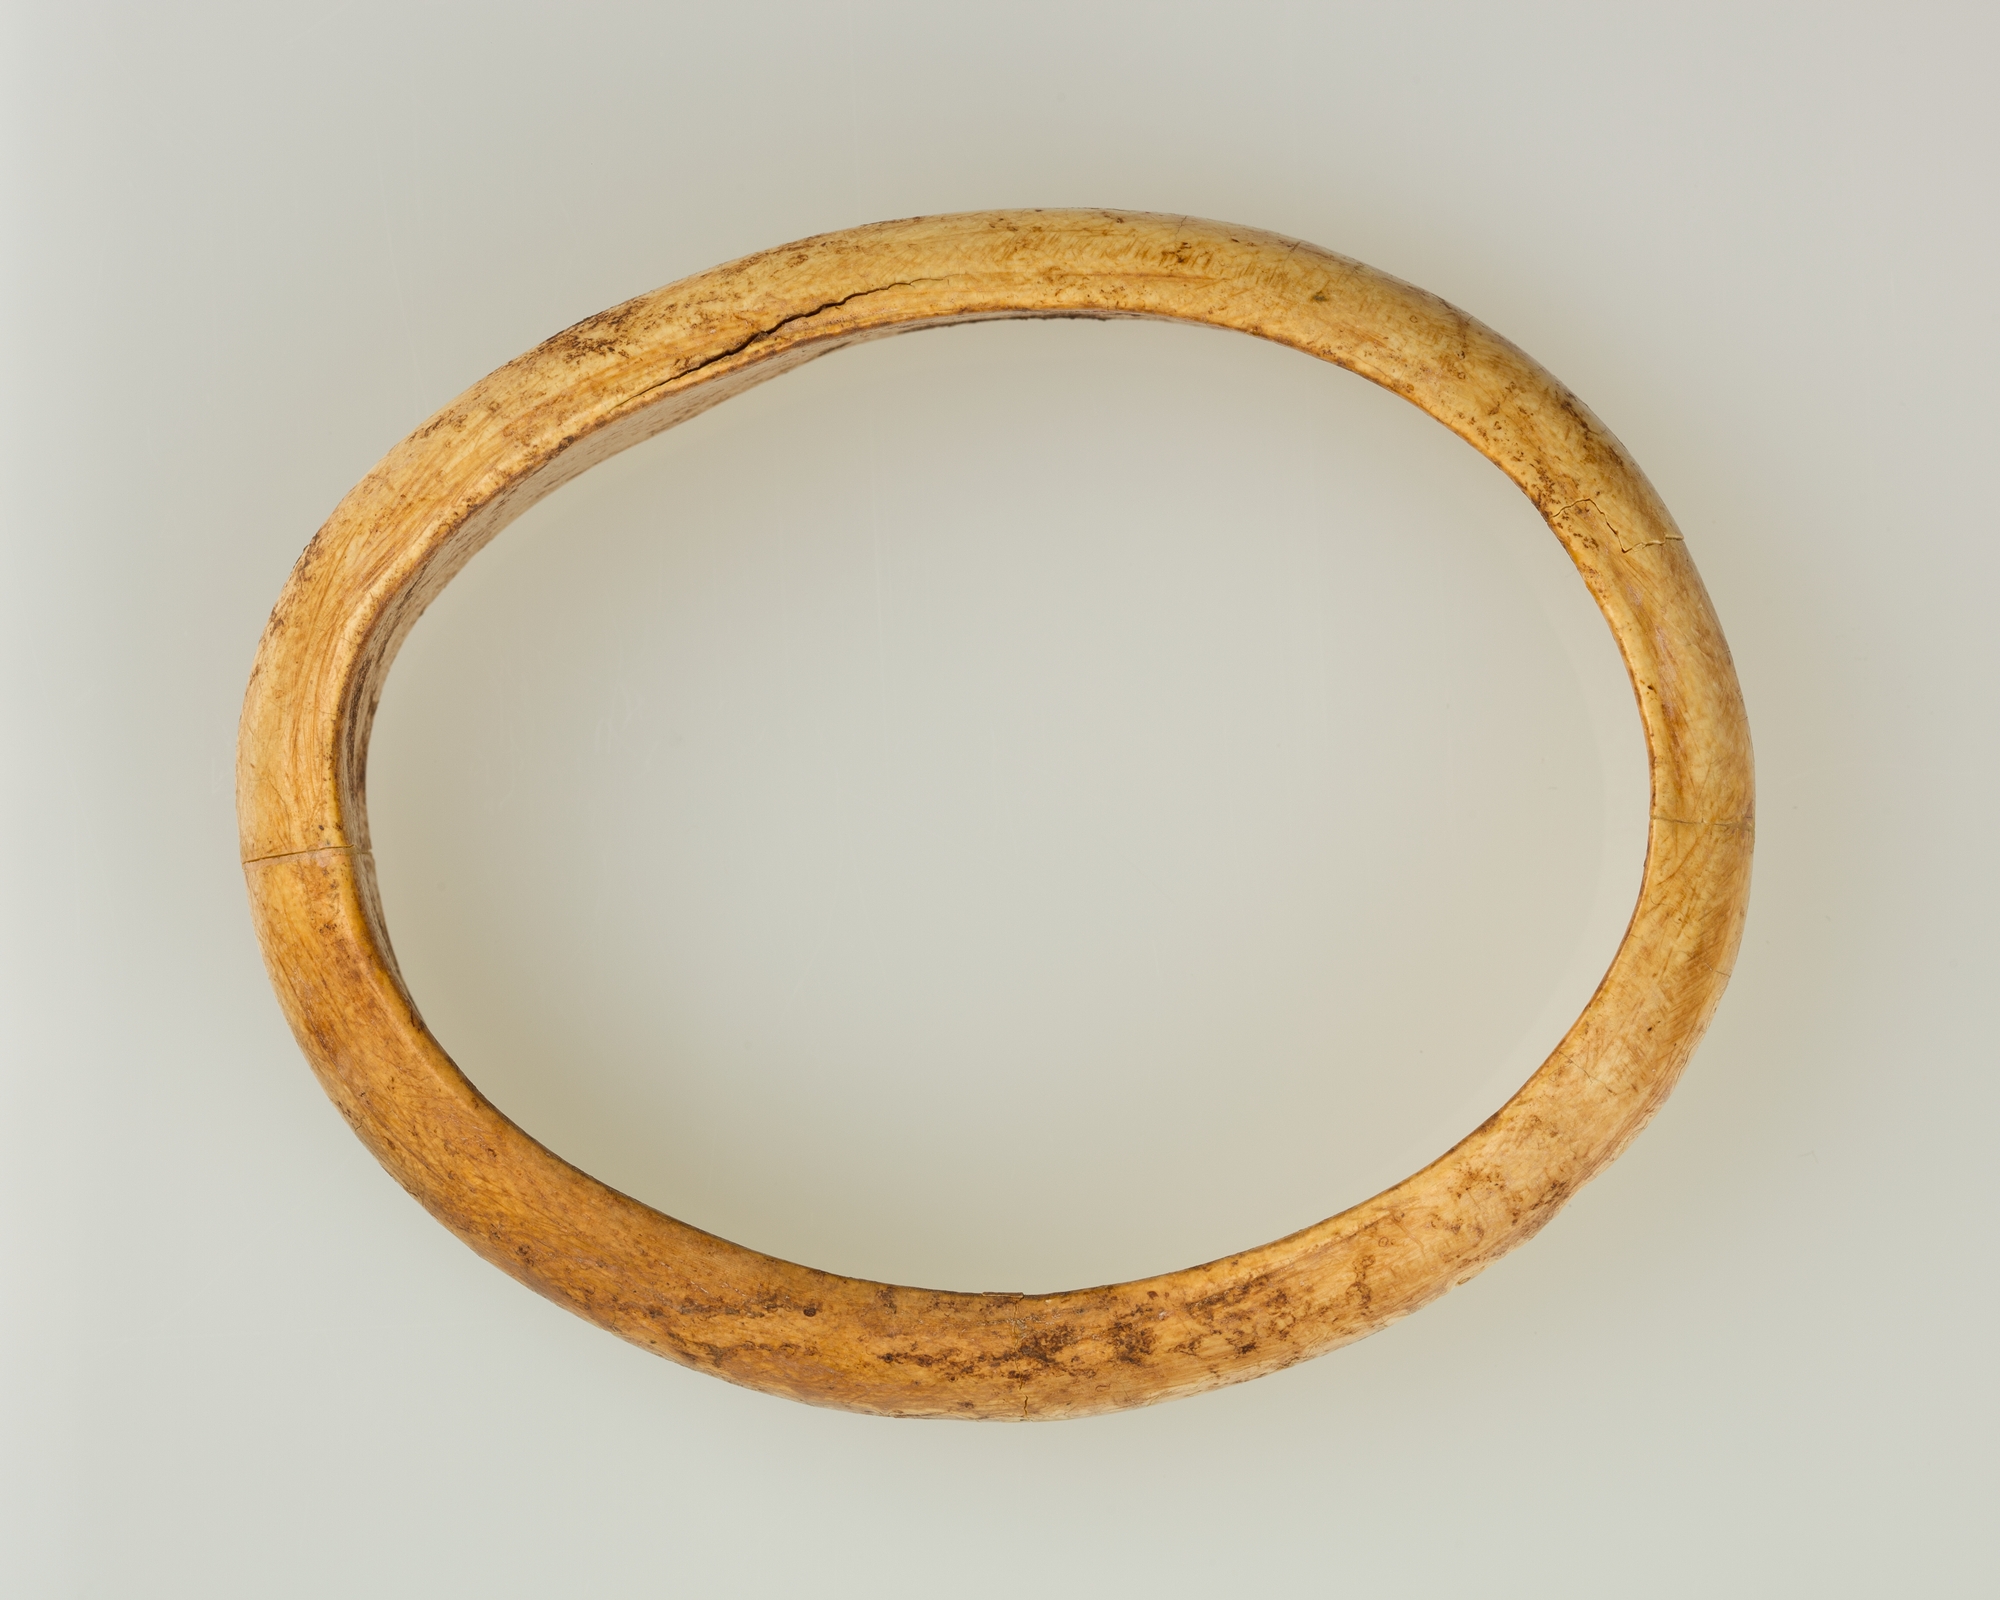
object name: bracelet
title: Ivory bracelet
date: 3850-3300 BCE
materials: ivory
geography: egypt